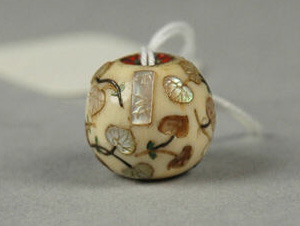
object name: ojime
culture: japanese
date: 1801-1900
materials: ivory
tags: leaves